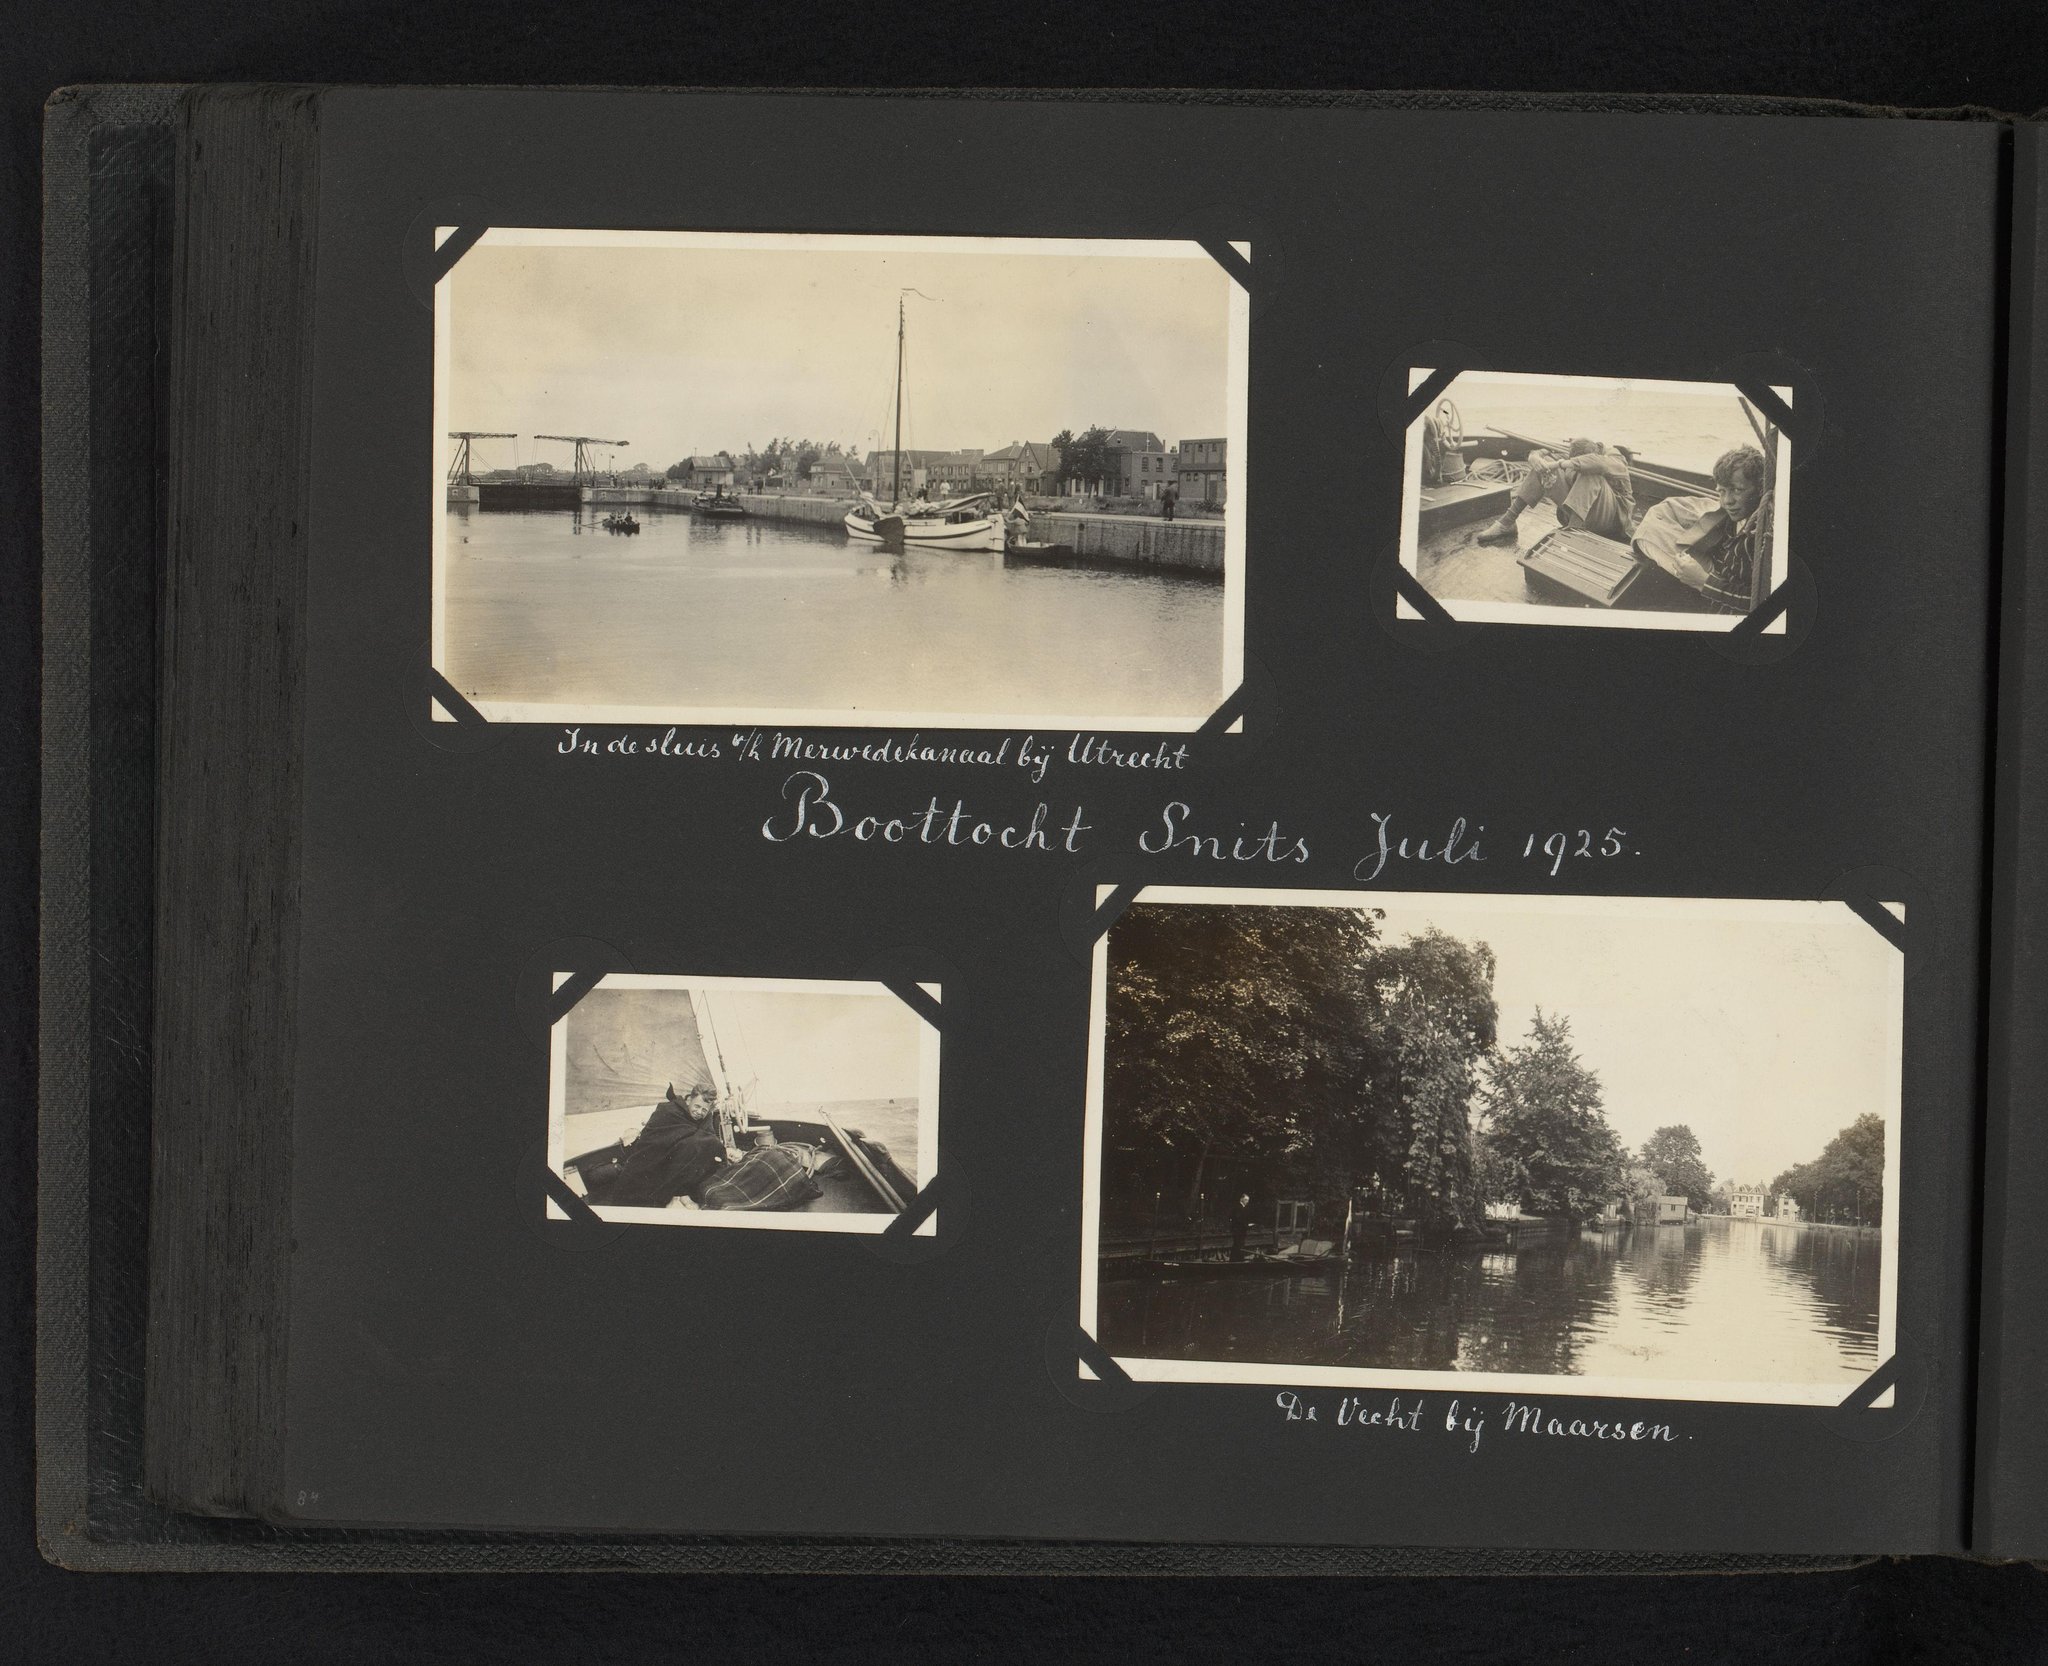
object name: photograph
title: Vier foto's van een boottocht met zeilboot de Snits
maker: hendrik herman van den berg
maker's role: amateurfotograaf, jurist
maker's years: 1875-1944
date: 1907-1925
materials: paper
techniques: gelatin silver print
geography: utrecht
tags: sailing-ship, sailing-boat, river, maarssen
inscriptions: inscription: ‘De Vecht bij Maarsen’, inscription: ‘In de sluis v/h Merwedekanaal bij Utrecht’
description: Deze foto's maken deel uit van een album.